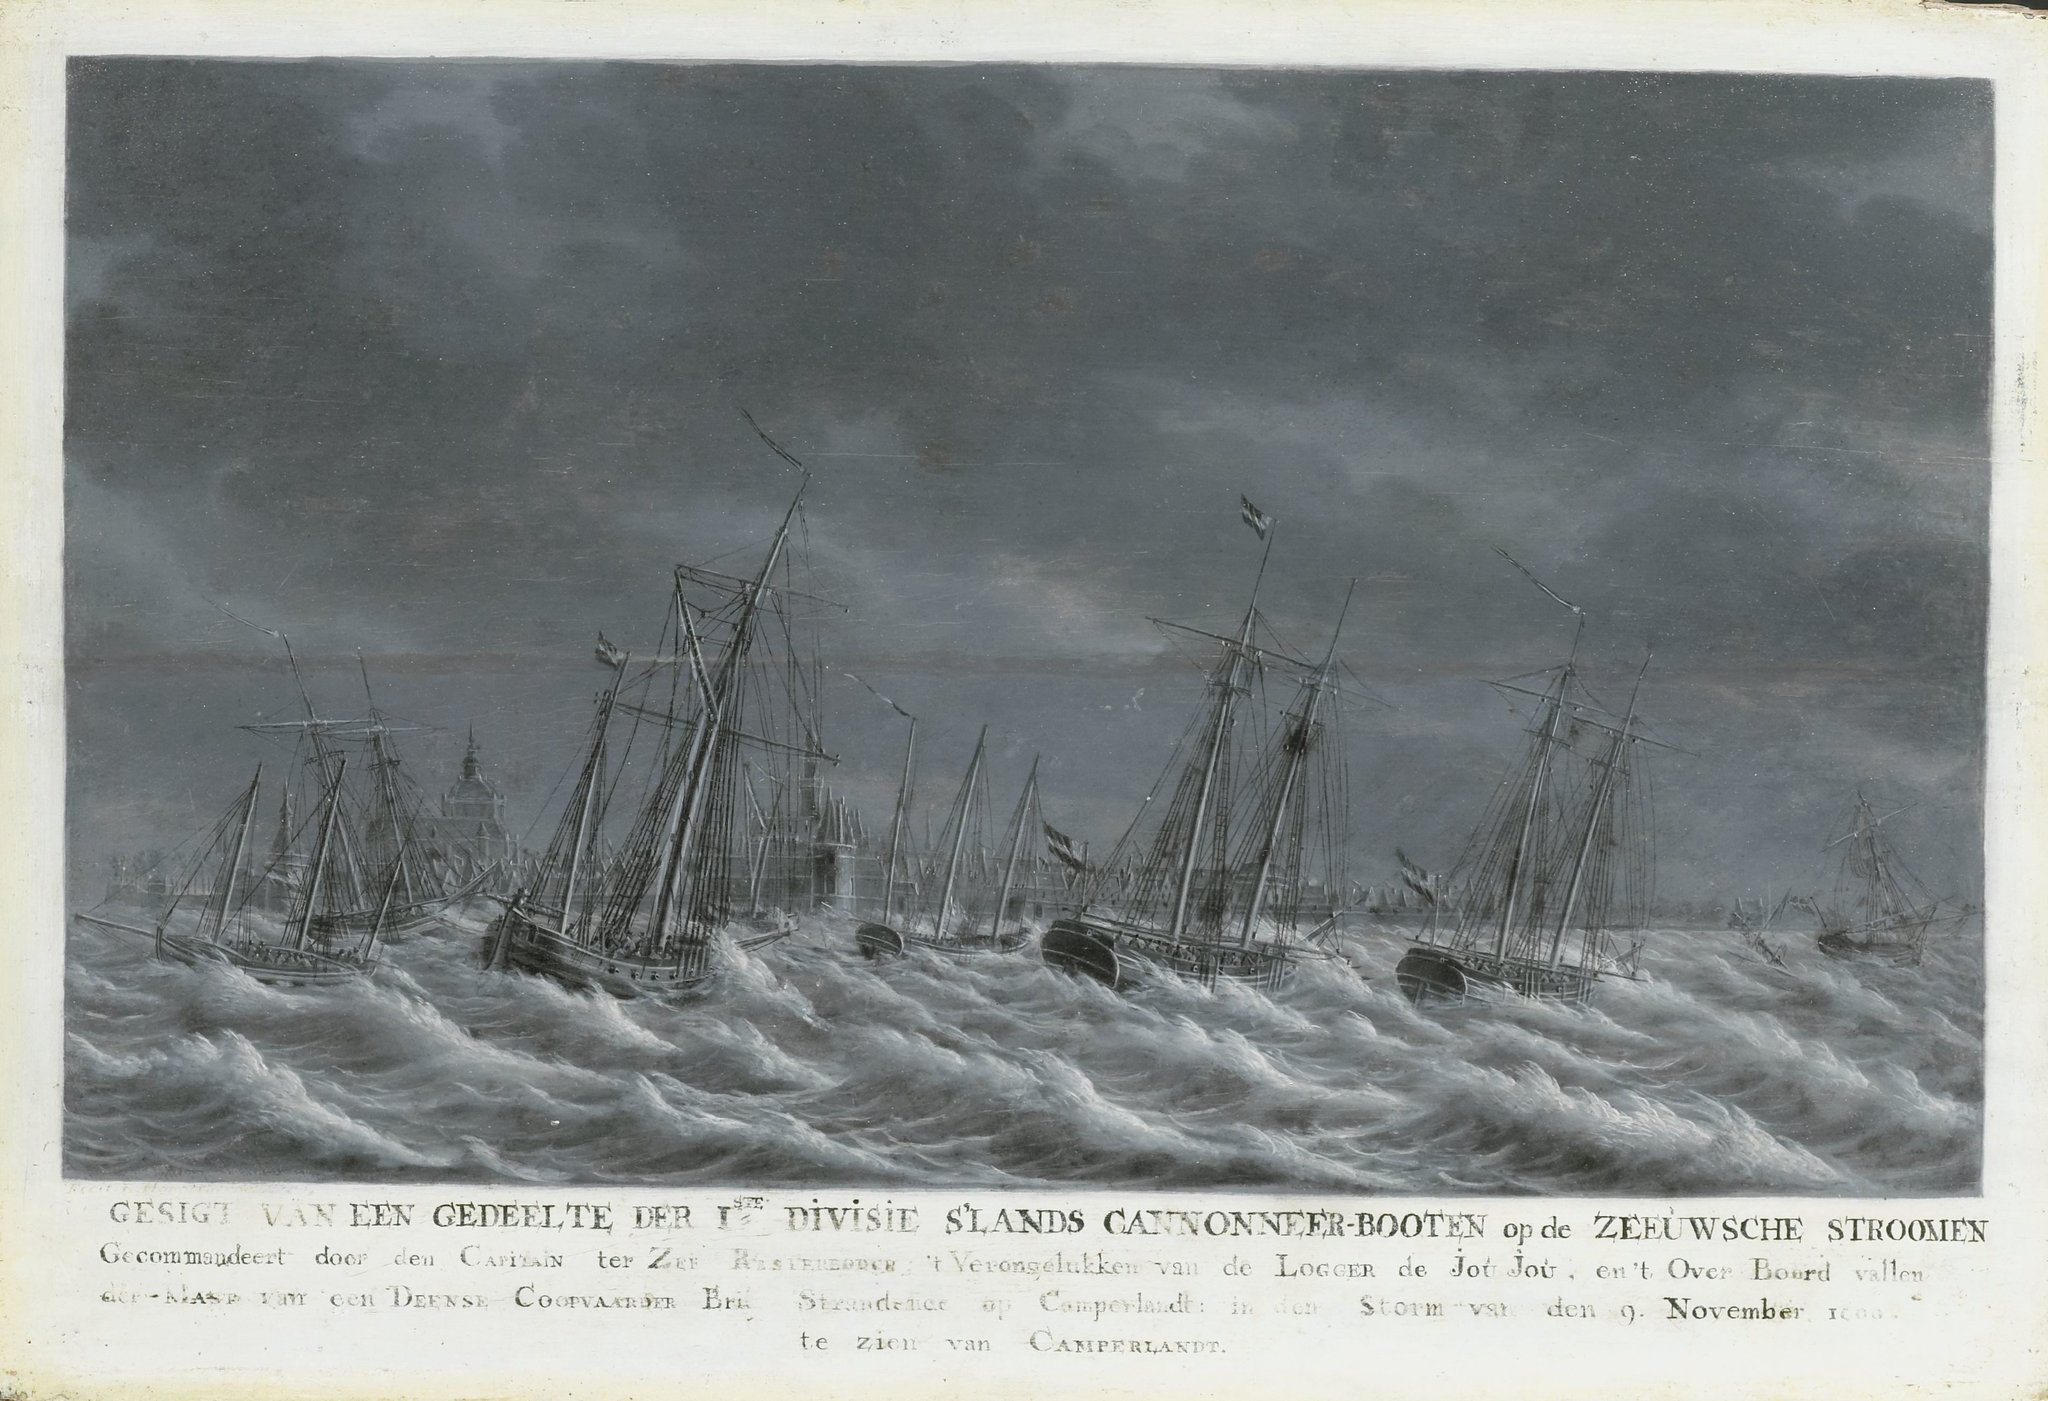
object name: painting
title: The Batavian Fleet off Veere, 1800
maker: engel hoogerheyden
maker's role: painter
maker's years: 1740-1809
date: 1800-1809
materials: oil, panel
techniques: grisaille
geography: middelburg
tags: storm at sea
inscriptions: inscription: ‘Gesigt van een Gedeelte der 1ste Divisie s'Lands Cannonneer-booten op de Zeeuwsche stroomen, gecommandeert door den Capitain ter Zee Resterbooch; 't Verongelukken van de Logger de Jou Jou, en 't Over Boord vallen der Mast van een Deense Coopvaarder Brik strandende op Camperlandt. in den Storm van den 9. November 1800, te zien van Camperlandt.’, signature: ‘Fecit E. Hoogerheyde’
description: Zeegezicht met de Bataafse vloot op woeste zee voor Veere, op 9 November 1800. Onder de voorstelling een onderschrift: Gesigt van een Gedeelte der 1ste Divisie s'Lands Cannonneer-booten op de Zeeuwsche stroomen, gecommandeert door den Capitain ter Zee Resterbooch; 't Verongelukken van de Logger de Jou Jou, en 't Over Boord vallen der Mast van een Deense Coopvaarder Brik strandende op Camperlandt. in den Storm van den 9. November 1800, te zien van Camperlandt.